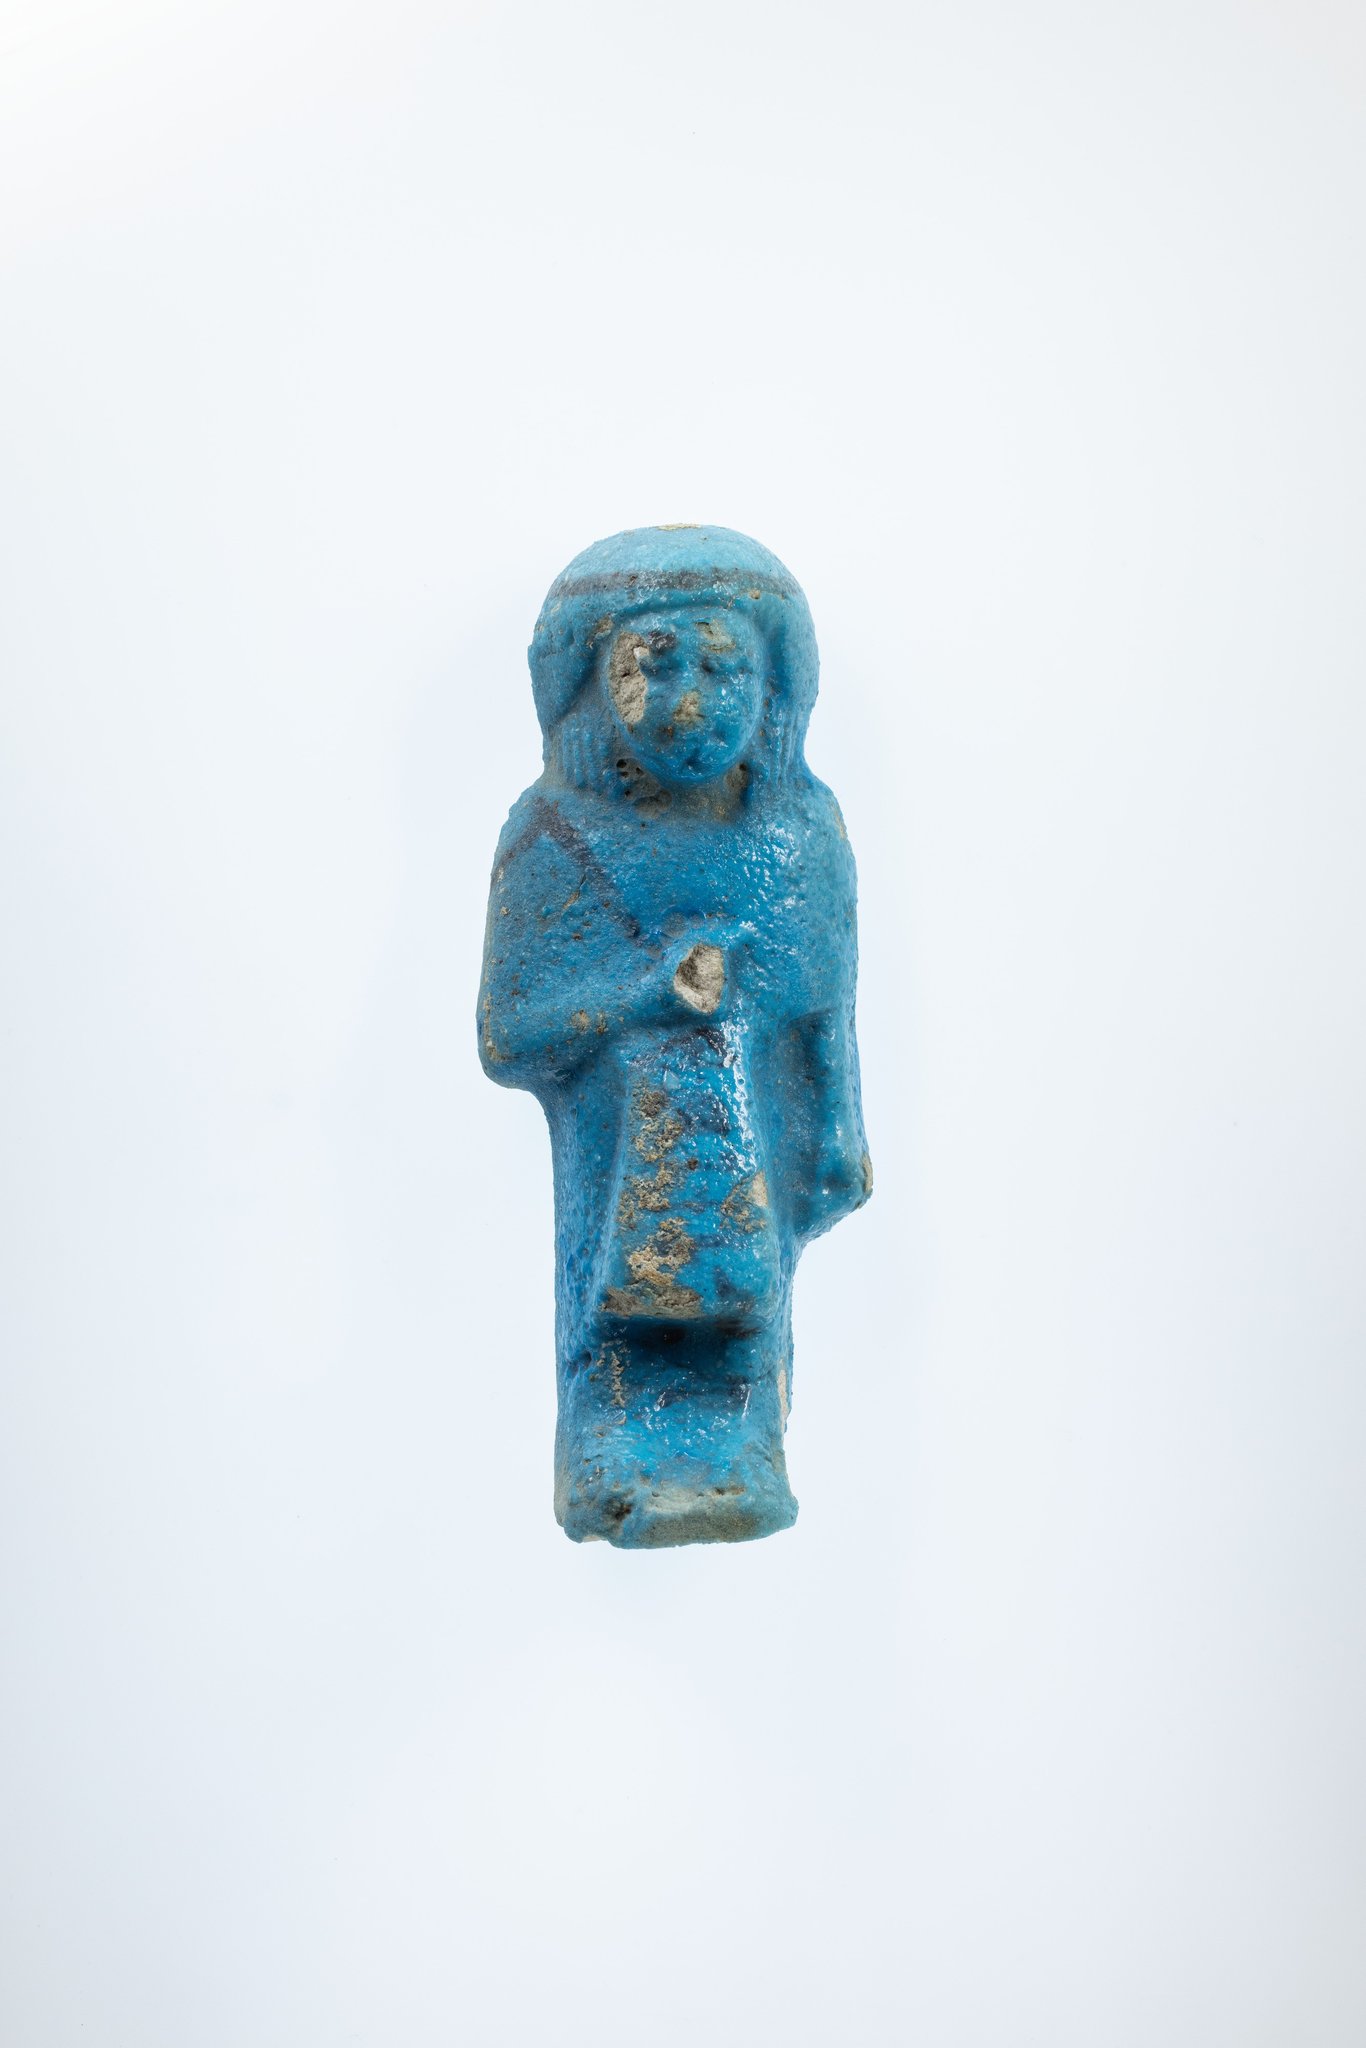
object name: shabti, nesenaset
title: Shabti of Nesenaset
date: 1070-945 BCE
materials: faience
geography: egypt